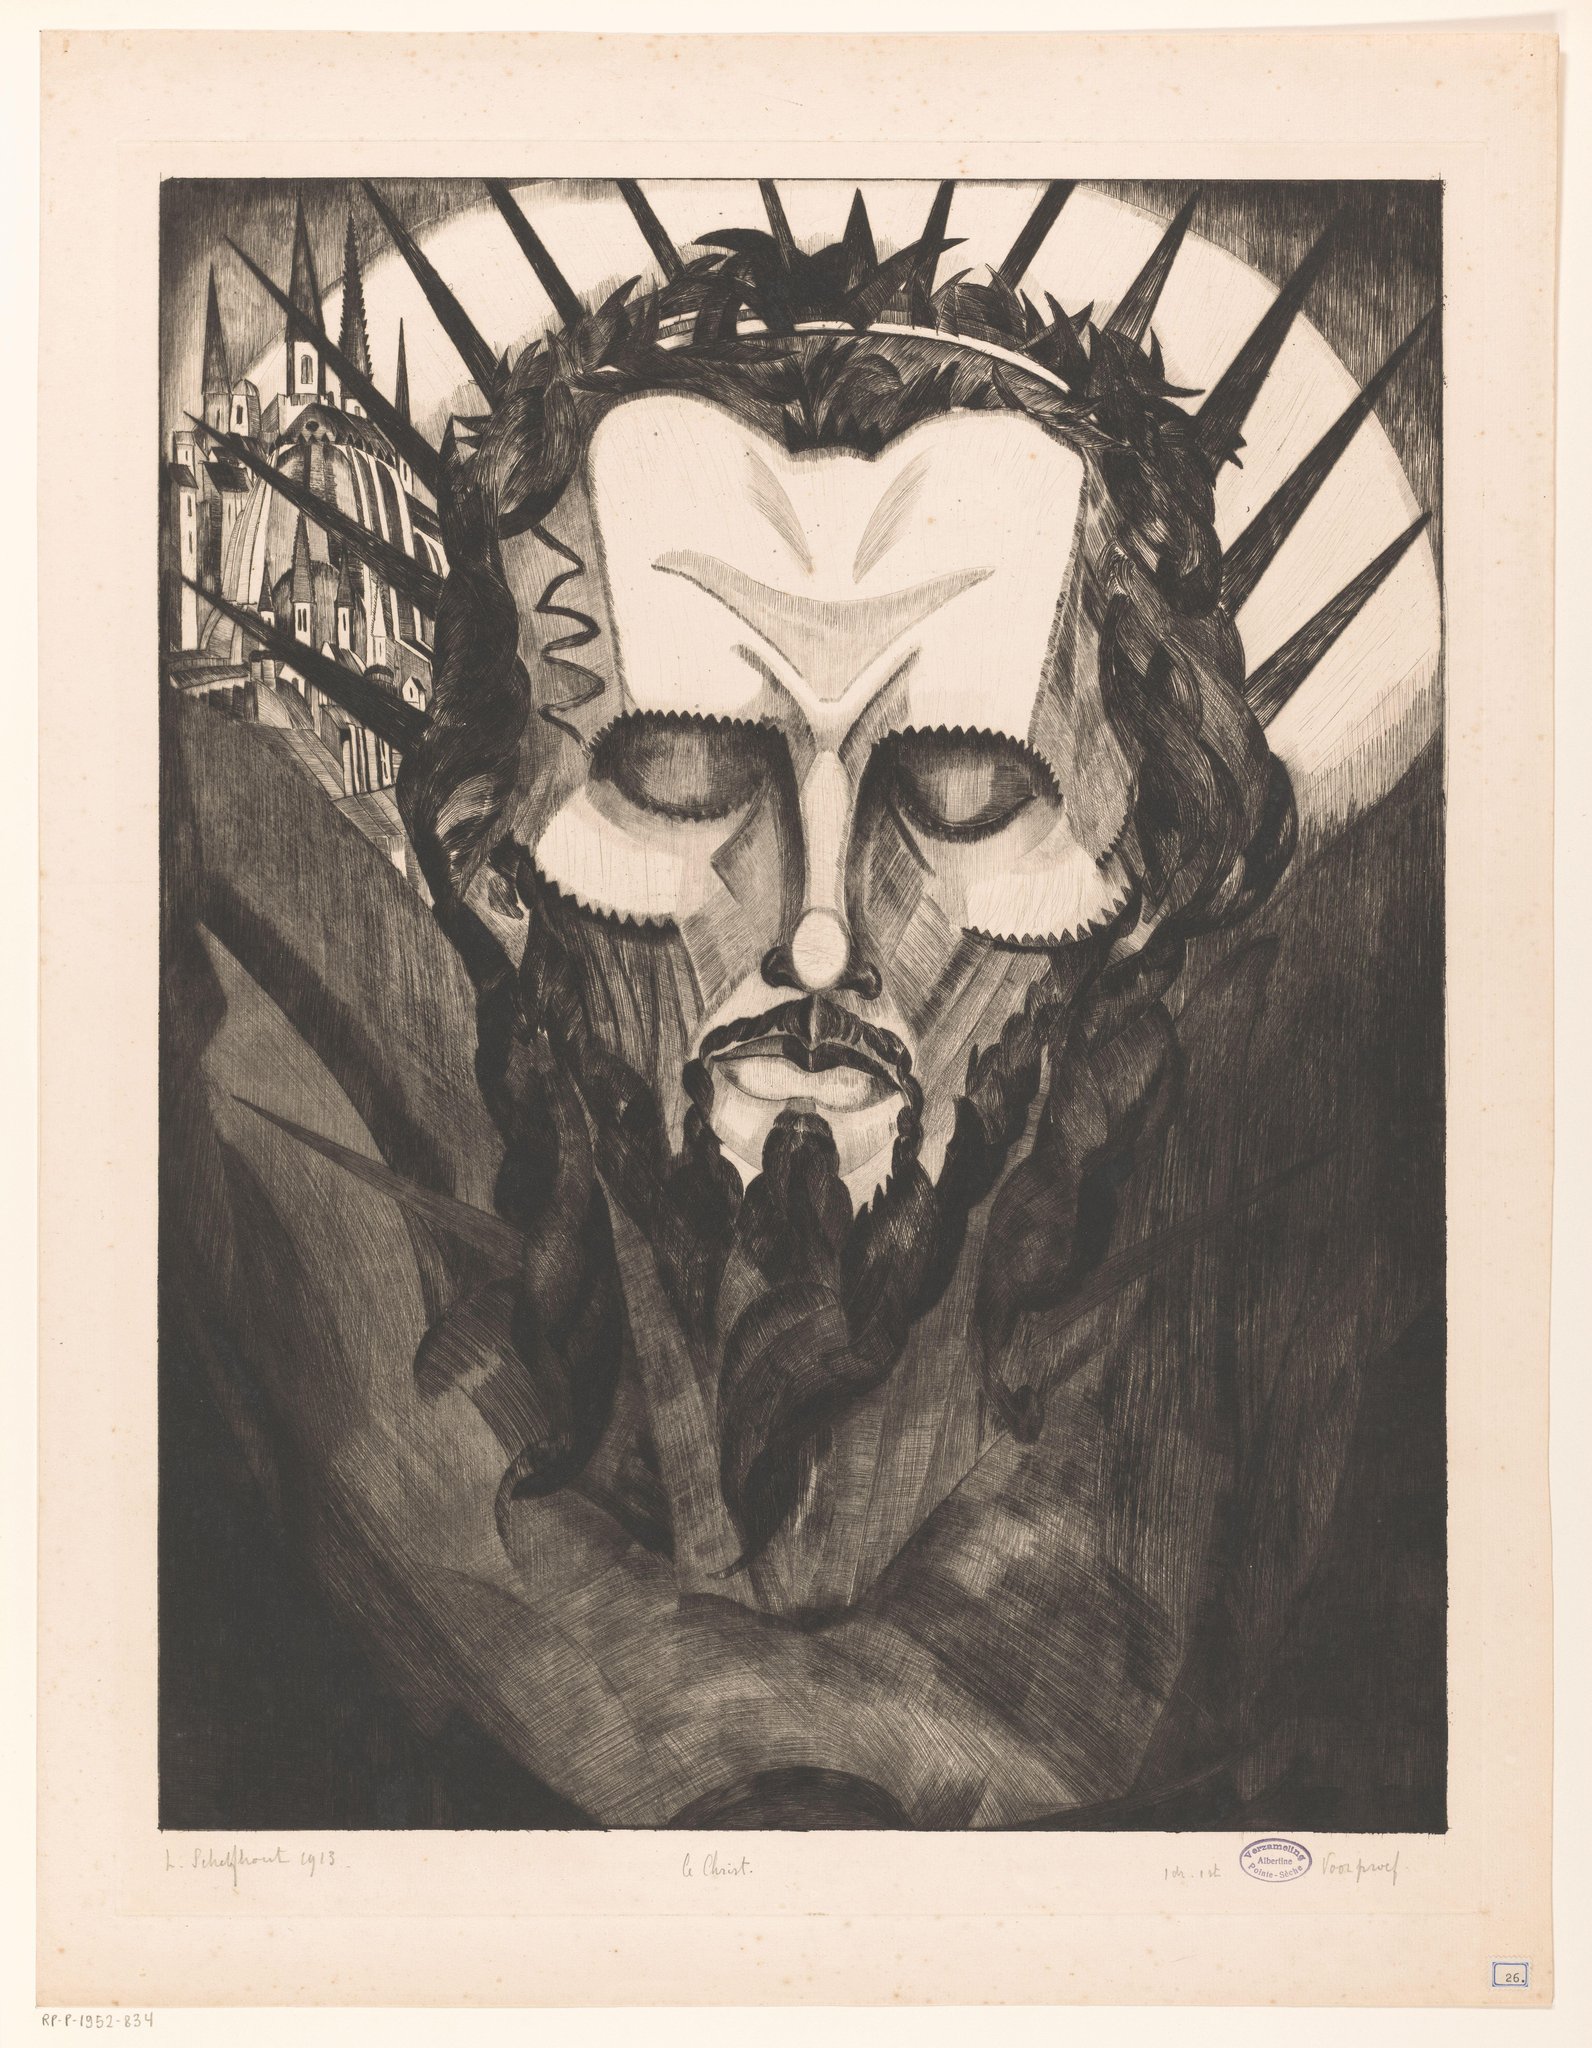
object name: print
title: Tête de Christ I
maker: lodewijk schelfhout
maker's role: draughtsman, print maker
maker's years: 1881-1943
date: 1913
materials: paper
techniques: drypoint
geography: netherlands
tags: landscape with tower or castle, crown of thorns ~ instruments of the passion, eyes closed, 'portraits' of christ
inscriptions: collector's mark: Lugt 2760, collector's mark: Lugt 5i, collector's mark: Lugt 2228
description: Christus met doornenkroon en gesloten ogen. Links op de achtergrond gebouwen met torens.